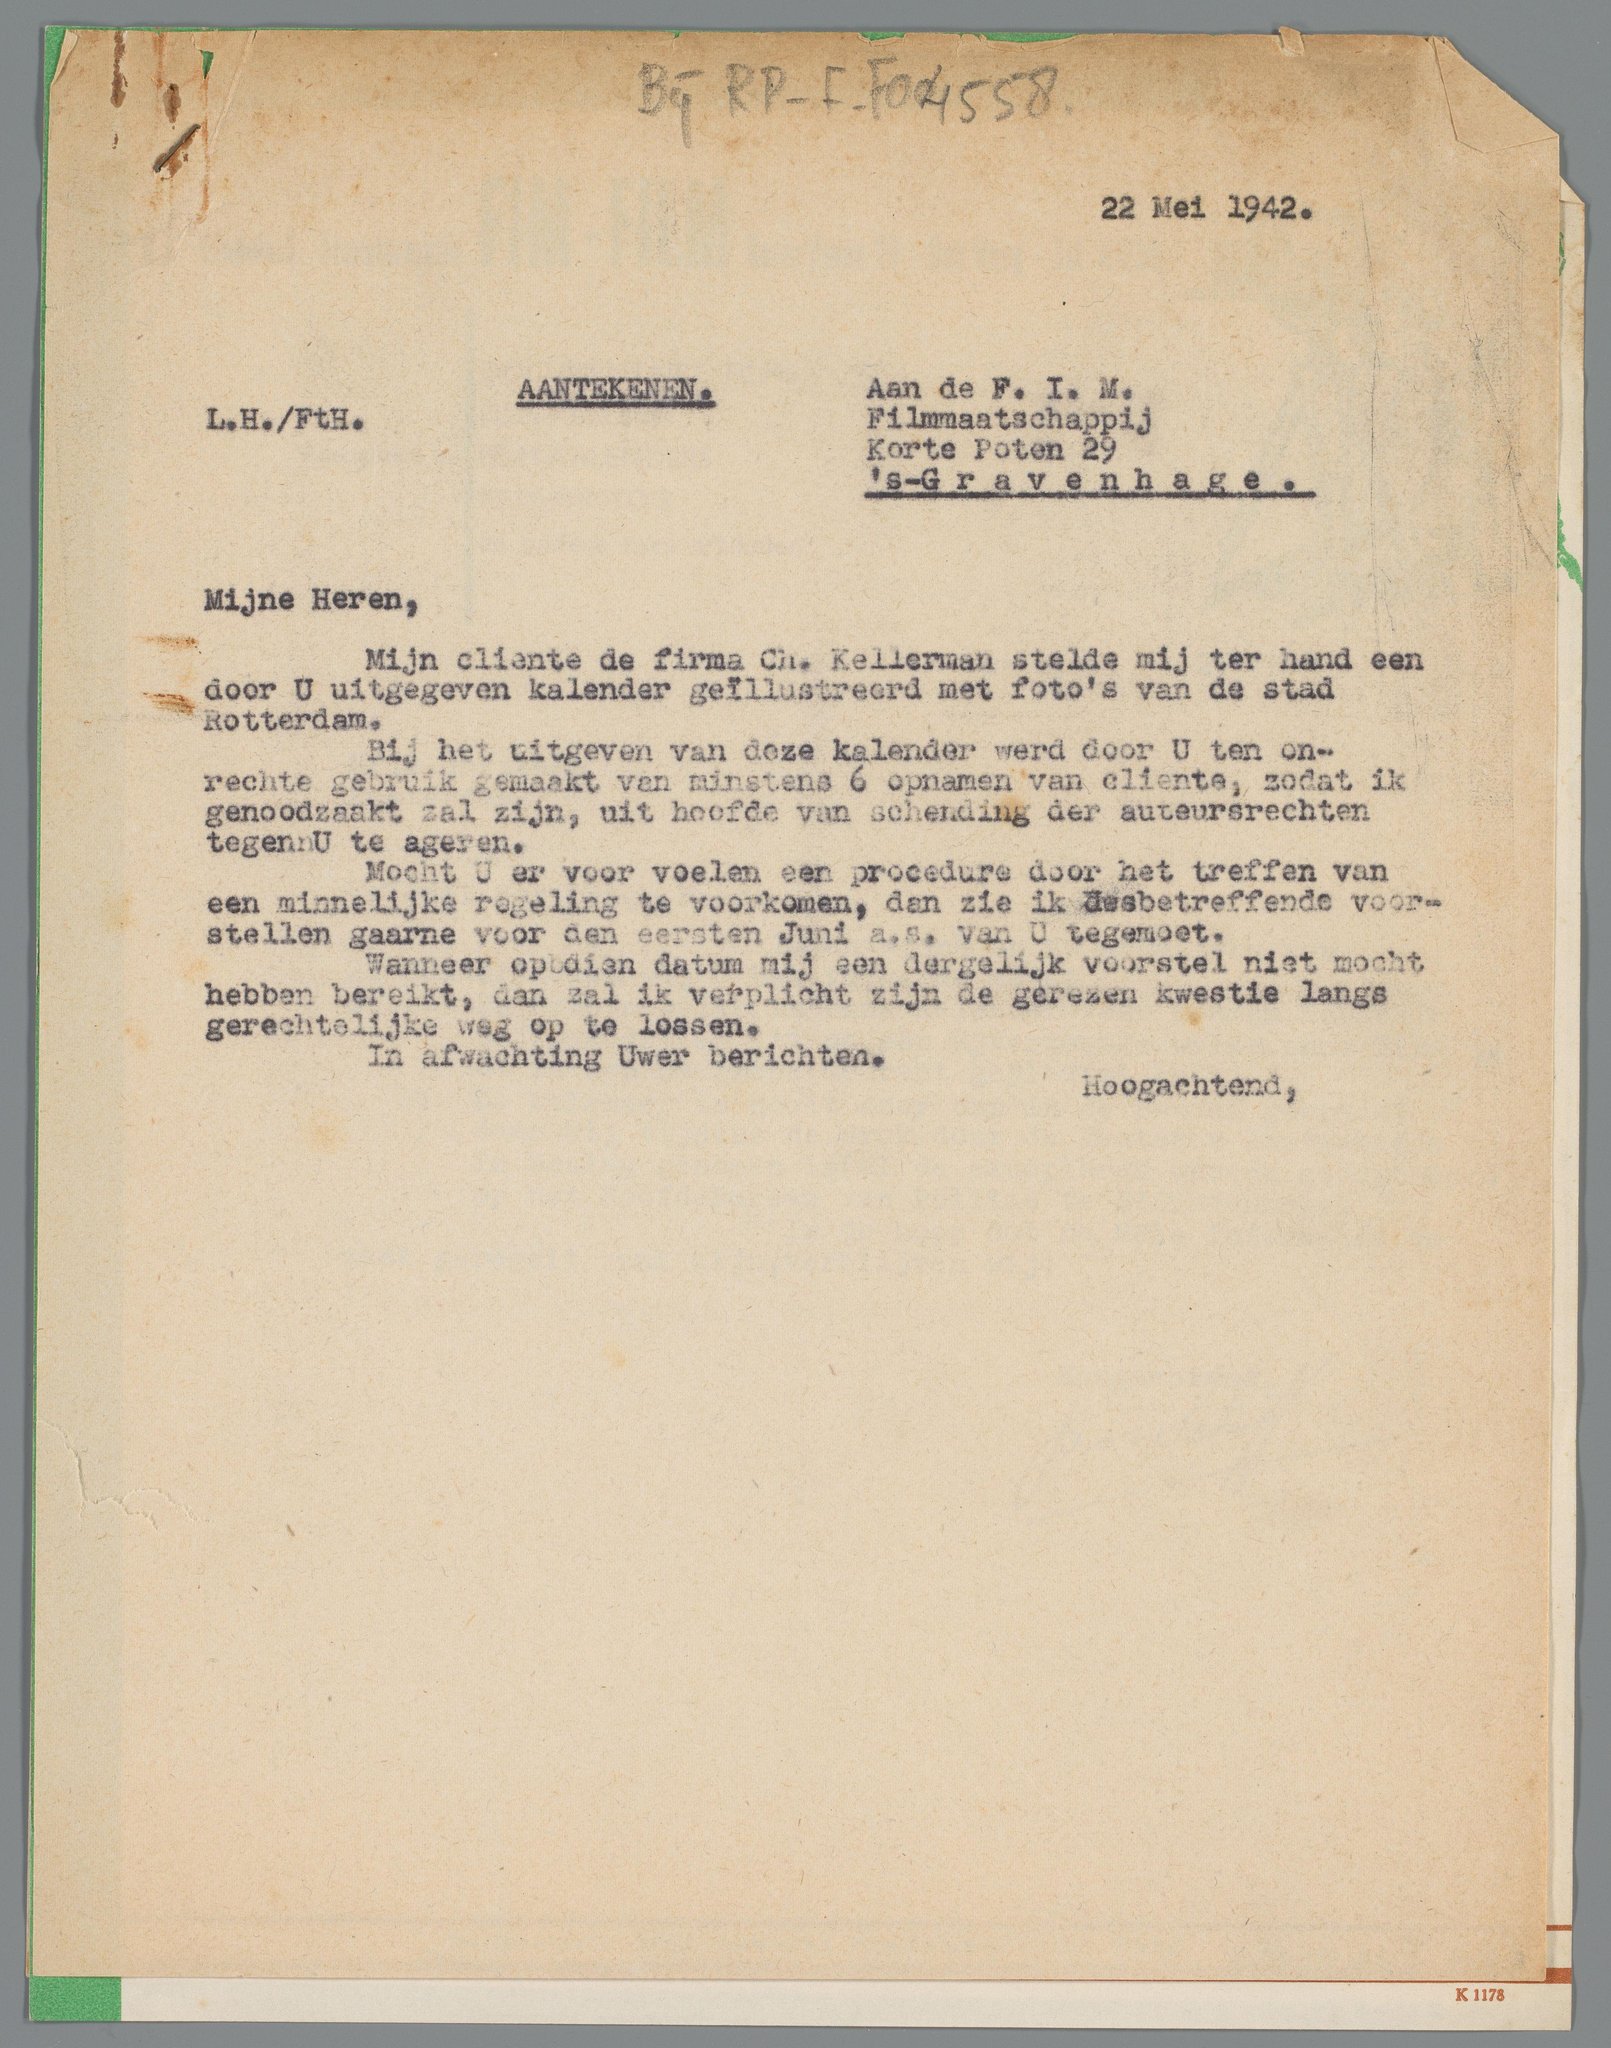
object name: correspondence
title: Correspondentie tussen L.J. Hartkamp en F.I.M. Filmmaatschappij over de auteursrechten van foto's gebruikt in een kalender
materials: paper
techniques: printing, printing block, typewriting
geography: the hague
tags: letter, envelope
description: Correspondentie bestaande uit vier brieven tussen L.J. Hartkamp en F.I.M. Filmmaatschappij over de auteursrechten van foto's gebruikt in een kalender voor het jaar 1942. Hartkamp vertegenwoordigt als advocaat zijn cliënt Ch. Kellerman die F.I.M. Filmmaatschappij waarschuwt tot een gerechtelijke procedure over te gaan wanneer laatstgenoemde niet met een passend voorstel komt. F.I.M. Filmmaatschappij beweert echter dat zij de foto's hebben gekocht en dat de kalender nooit officieel is uitgegeven wegens inbeslagname door de Duitse invallers.